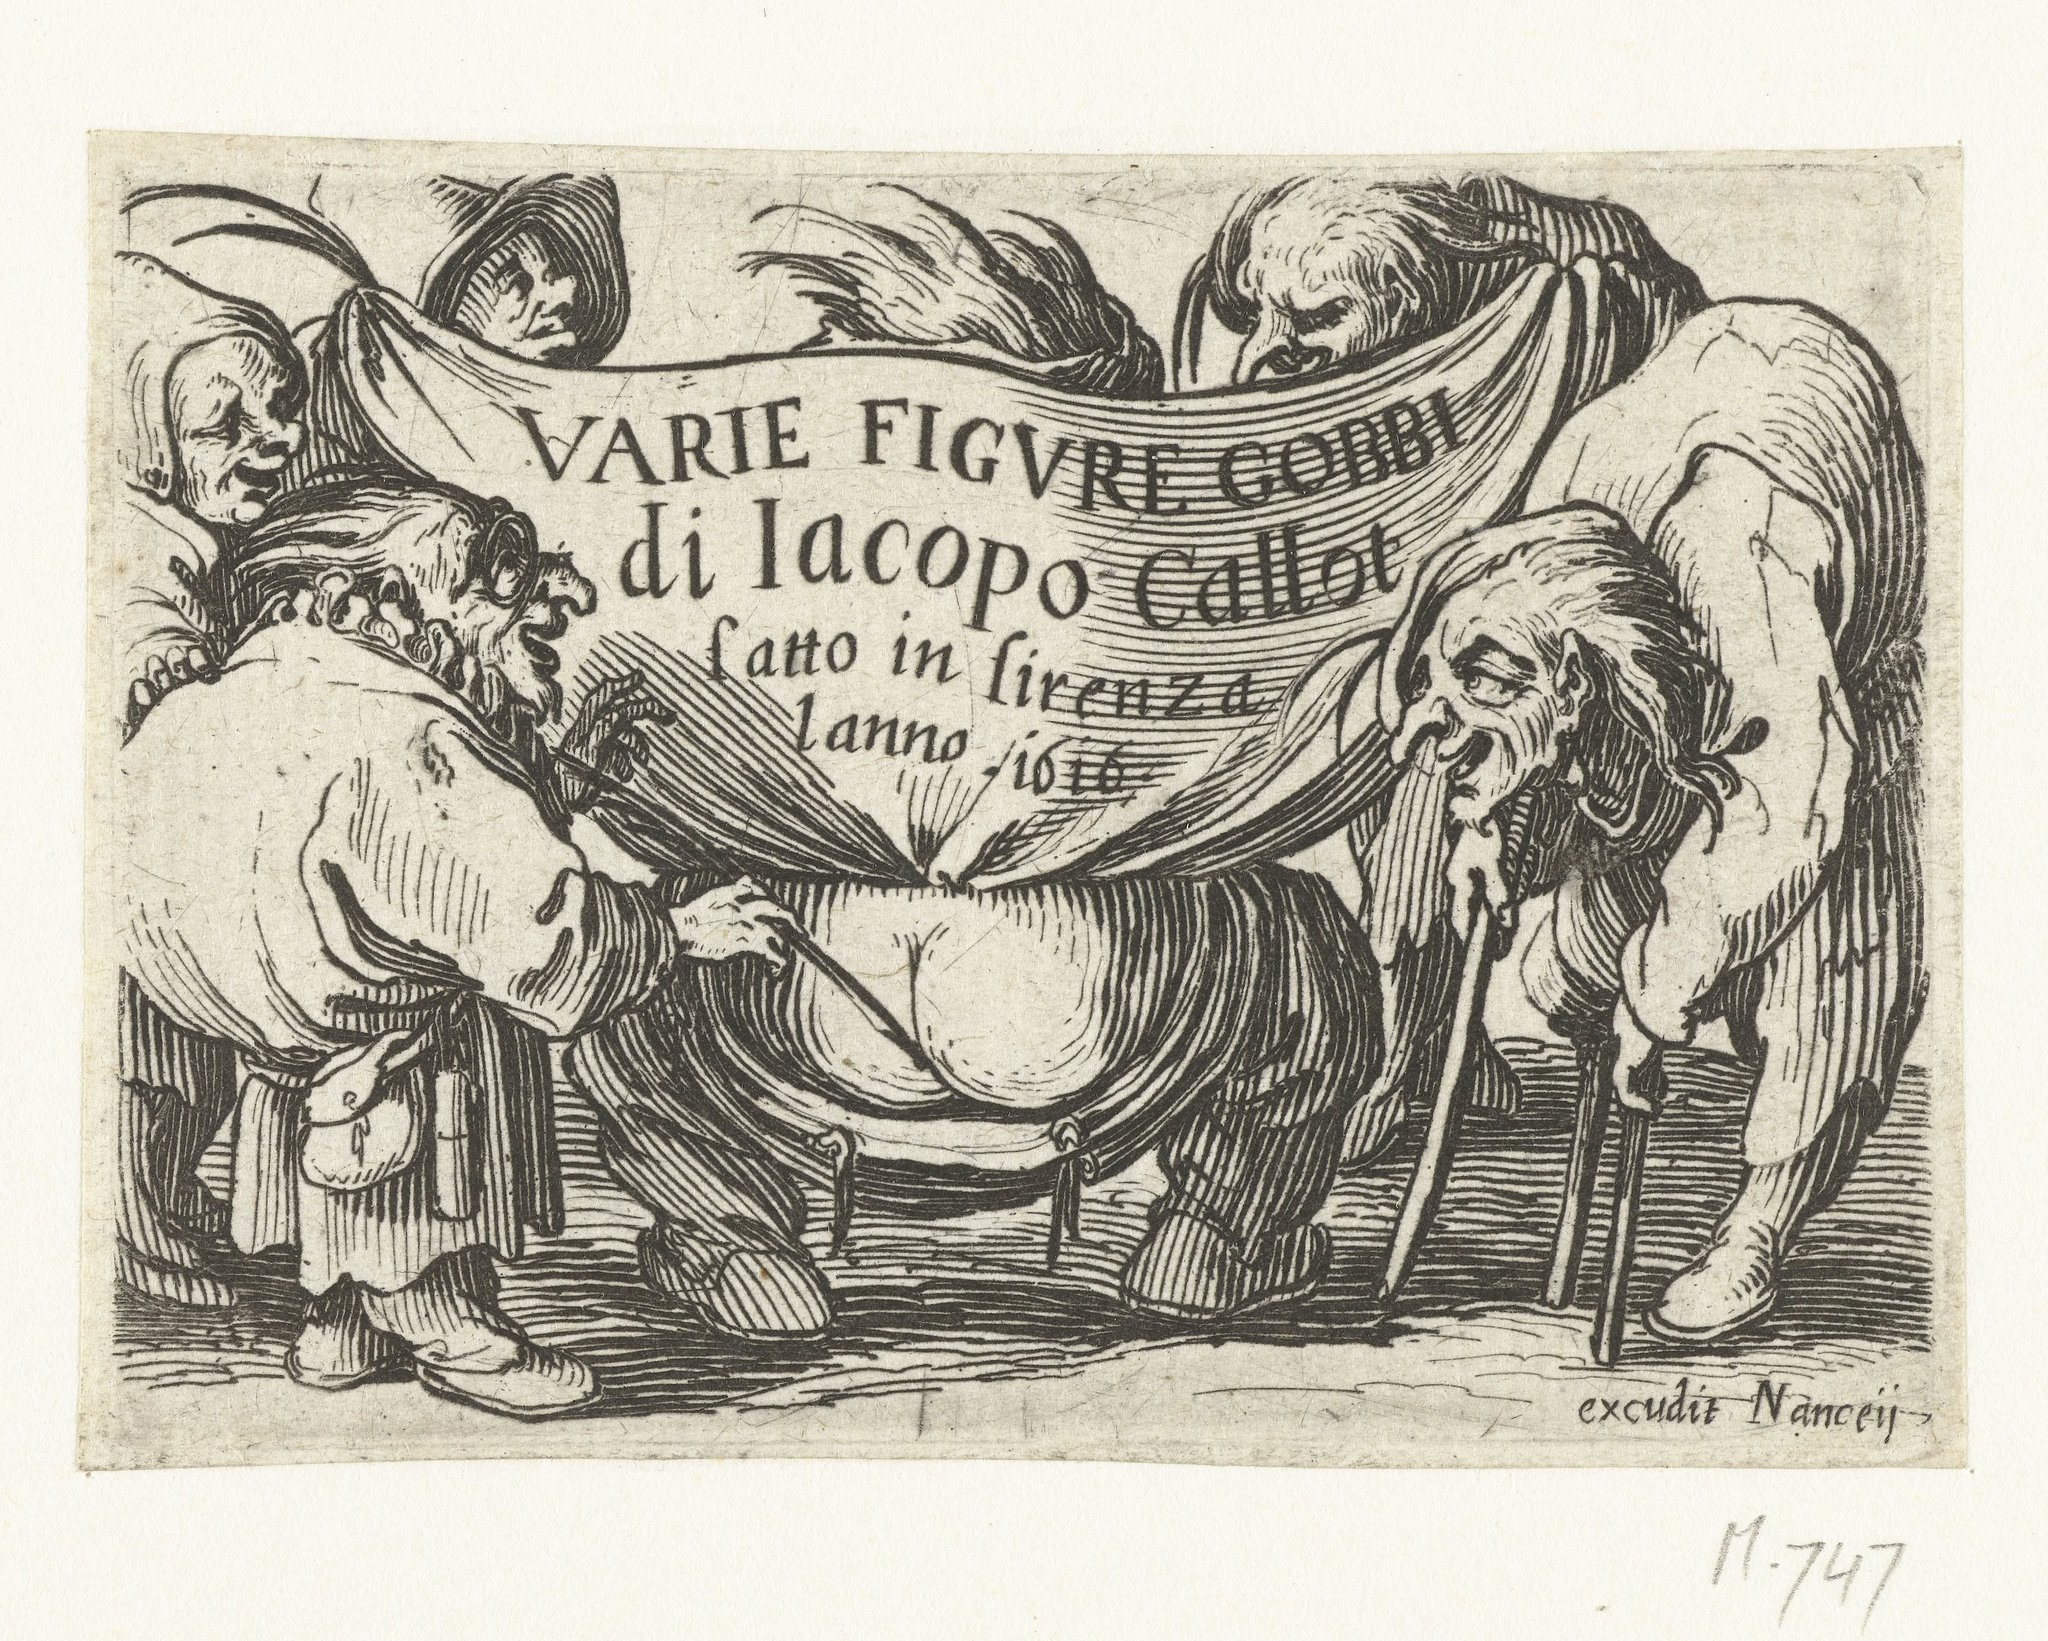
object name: titelprent, frontispice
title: Titelblad voor prentserie 'Diverse gebochelden'/'Varie figure gobbi di Jacopo Callot'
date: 1621-1625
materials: paper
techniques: engraving, etching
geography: nancy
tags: crutches, wooden leg, little people, buttocks, 'partes posteriores', hunchback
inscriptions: collector's mark: Lugt 240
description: Vijf kleine mensen (karikaturen), enkele gebocheld, staan om een zesde figuur heen. Deze zit op de hurken met ontblote billen, terwijl twee omstanders zijn jas of hemd omhoog houden. Op de opgetrokken kleding staan titel en maker van de prentreeks. Dit is namelijk de titelprent voor een serie van 20 prenten met groteske figuren; vrijwel al die figuren zijn karikaturen van kleine mensen, velen zijn gebocheld.